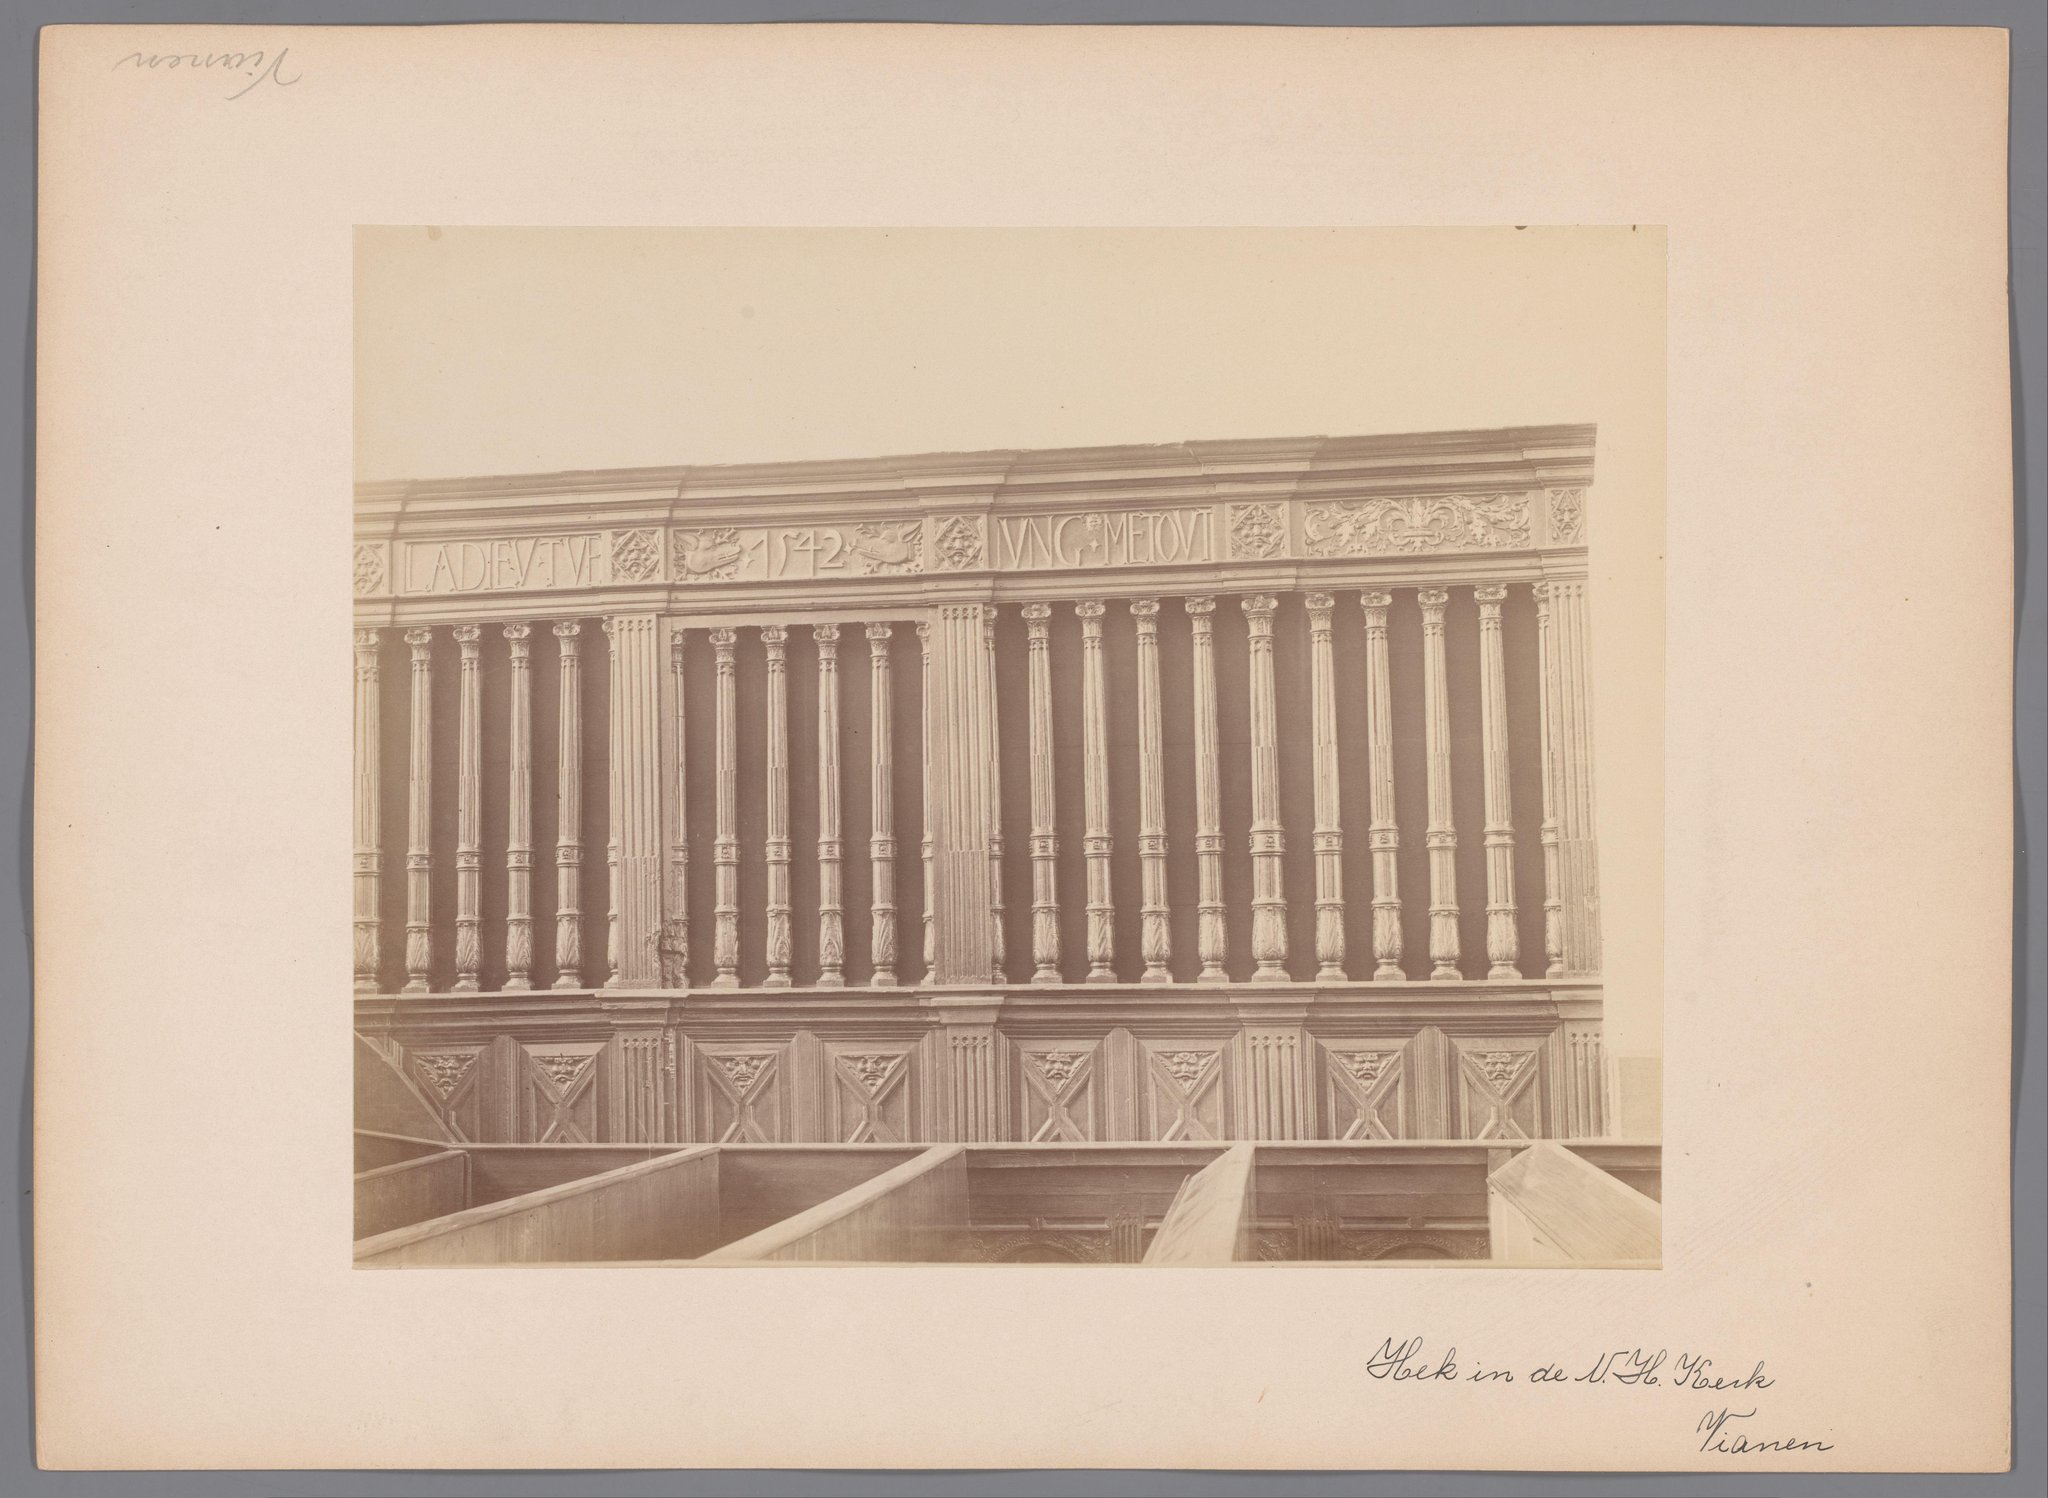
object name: photograph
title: Hek in de Grote Kerk te Vianen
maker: anoniem (monumentenzorg)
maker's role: fotograaf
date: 1890-1920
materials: cardboard, photographic support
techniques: albumen print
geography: grote kerk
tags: parts of church interior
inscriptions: annotation: ‘Vianen/ Hek in de Ned. Herv. Kerk’, annotation: ‘Hek in de N.H. Kerk/ Vianen’